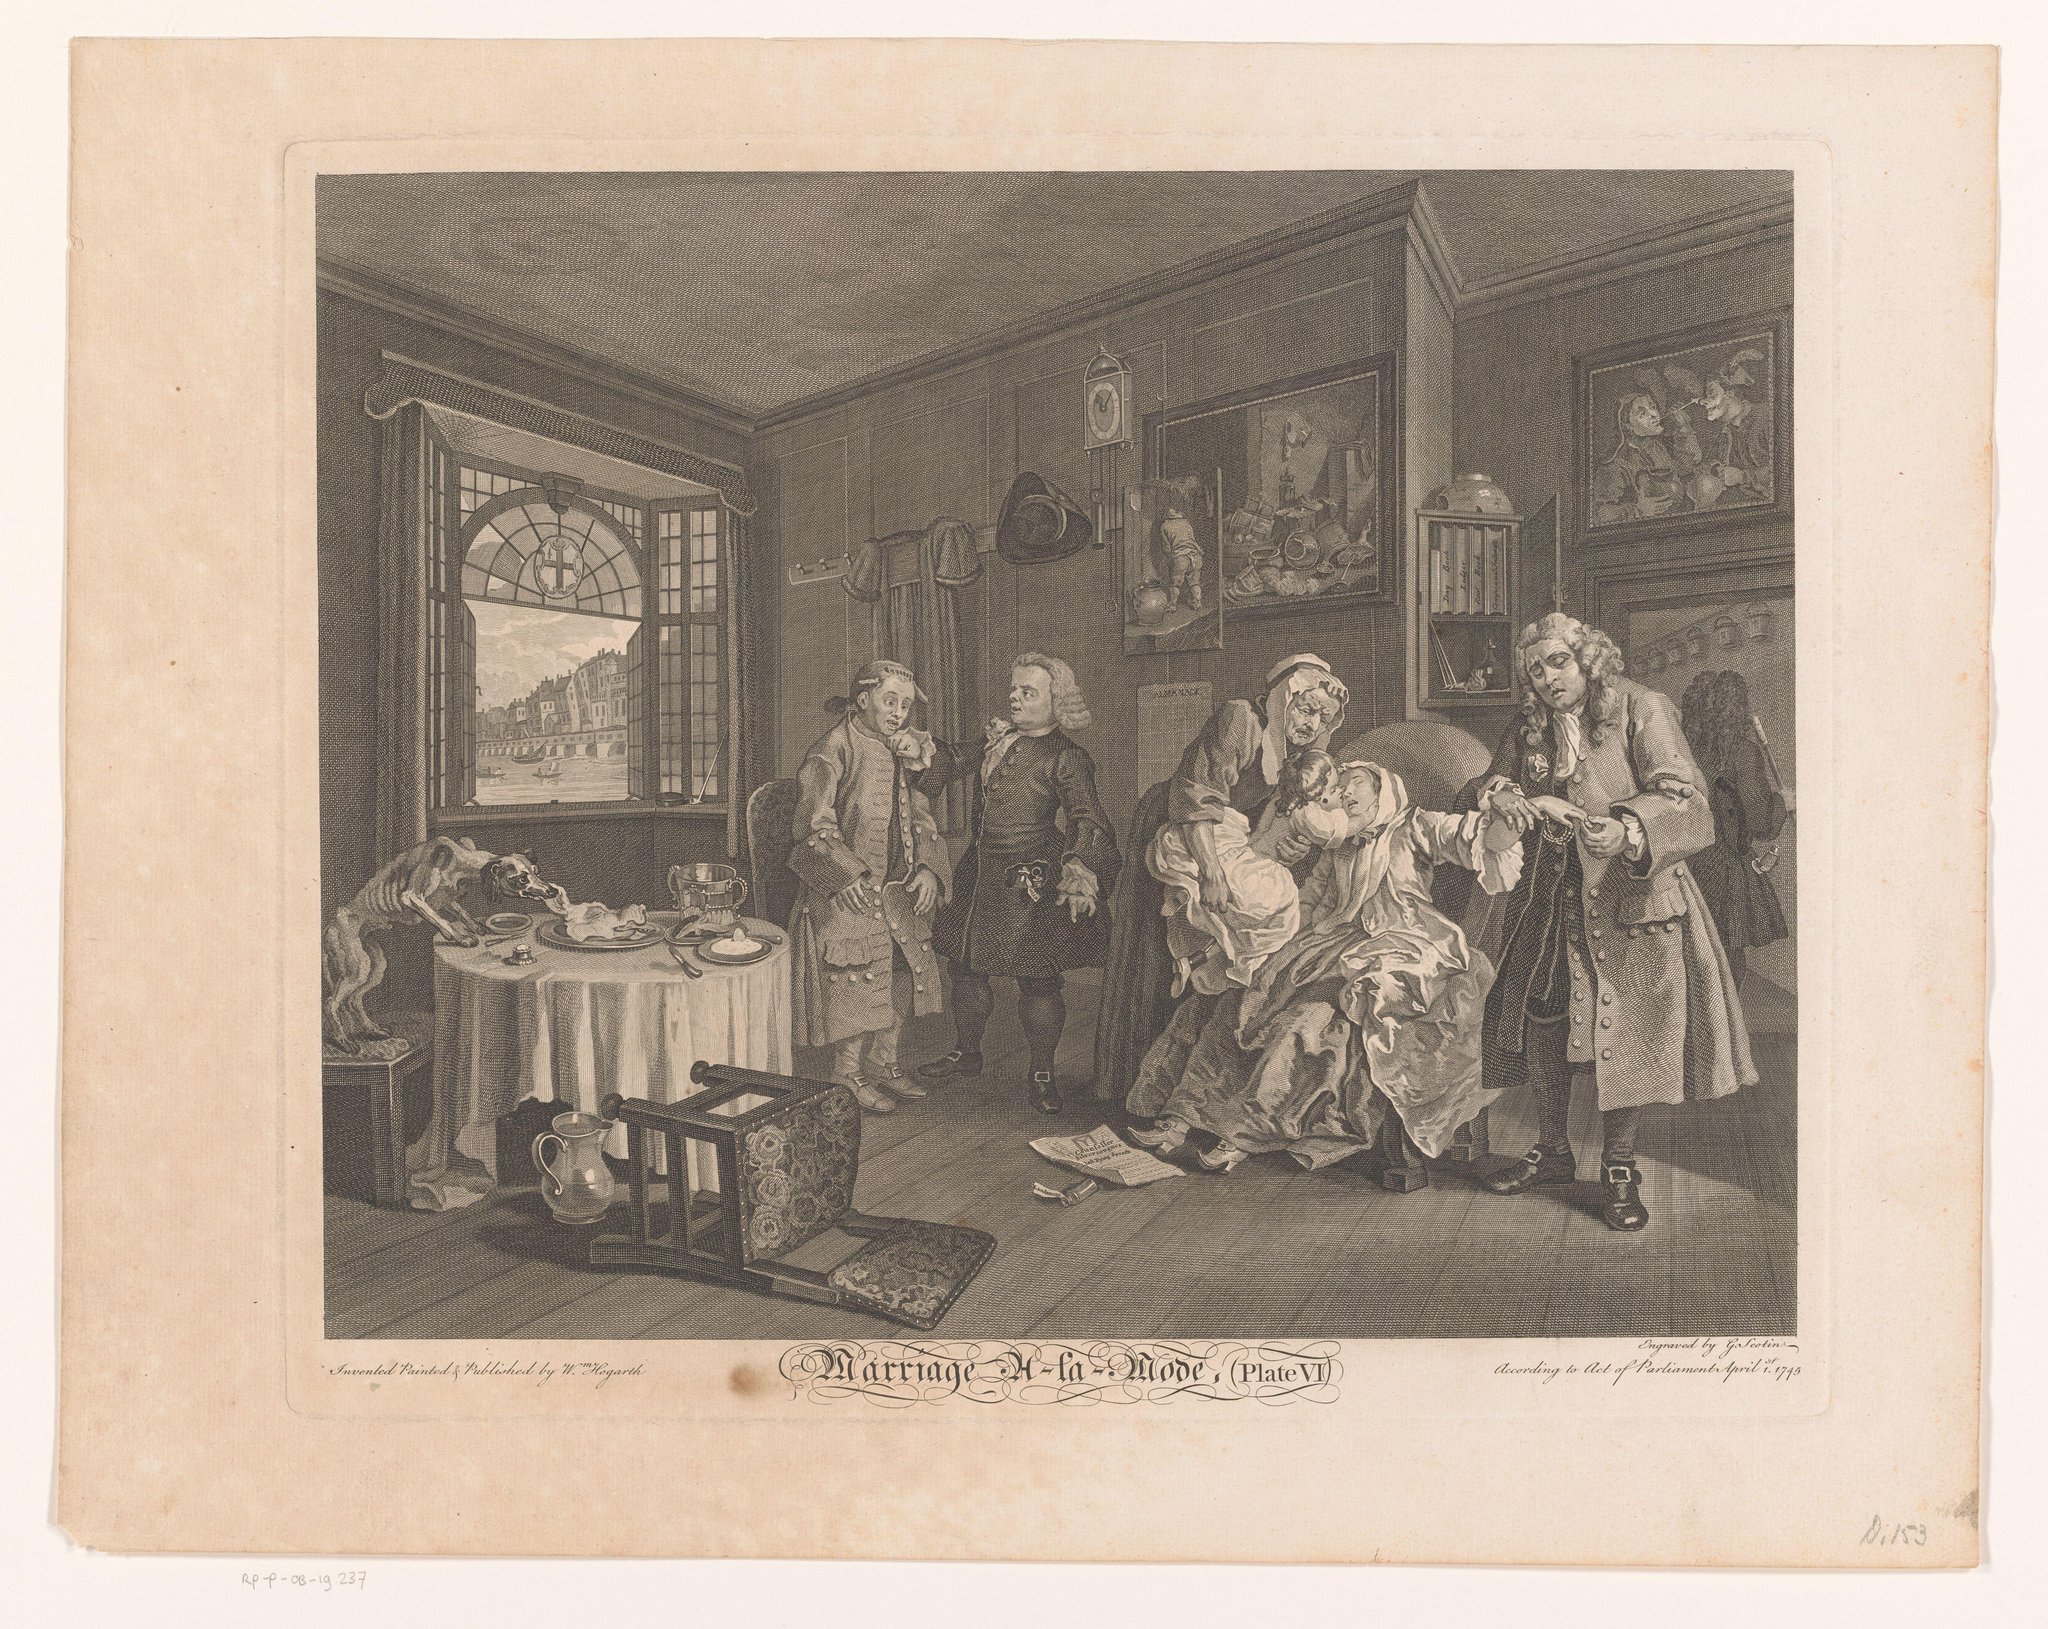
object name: cartoon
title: Interieur met de gravin stervend in een stoel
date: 1704-1745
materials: paper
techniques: etching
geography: london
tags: pharmacist, druggist, apothecary; pharmacy, drugstore, dispensing chemist, death of an adult person, wedding ring, seeking death, suicide, violent death by poison, satire on marriage, dog, london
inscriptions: collector's mark: Lugt 2228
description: Bij de voeten van de gravin ligt een nieuwsartikel waarin staat dat Silvertongue is opgehangen voor het vermoorden van haar man. Haar jonge kind wordt door een oude vrouw opgetild om haar een laatste kus te geven. Het kind heeft syfilis, te zien aan de donkere vlek in haar gezicht en de spalk om haar been. De vader van de gravin verwijdert haar trouwring. Een apotheker grijpt een bediende bij zijn kraag en wijst naar een fles laudanum waarmee de gravin suïcide heeft gepleegd. Rechts verlaat een arts de kamer. Links eet een magere hond een varkenskop van een bord op tafel en ligt een omgevallen stoel.